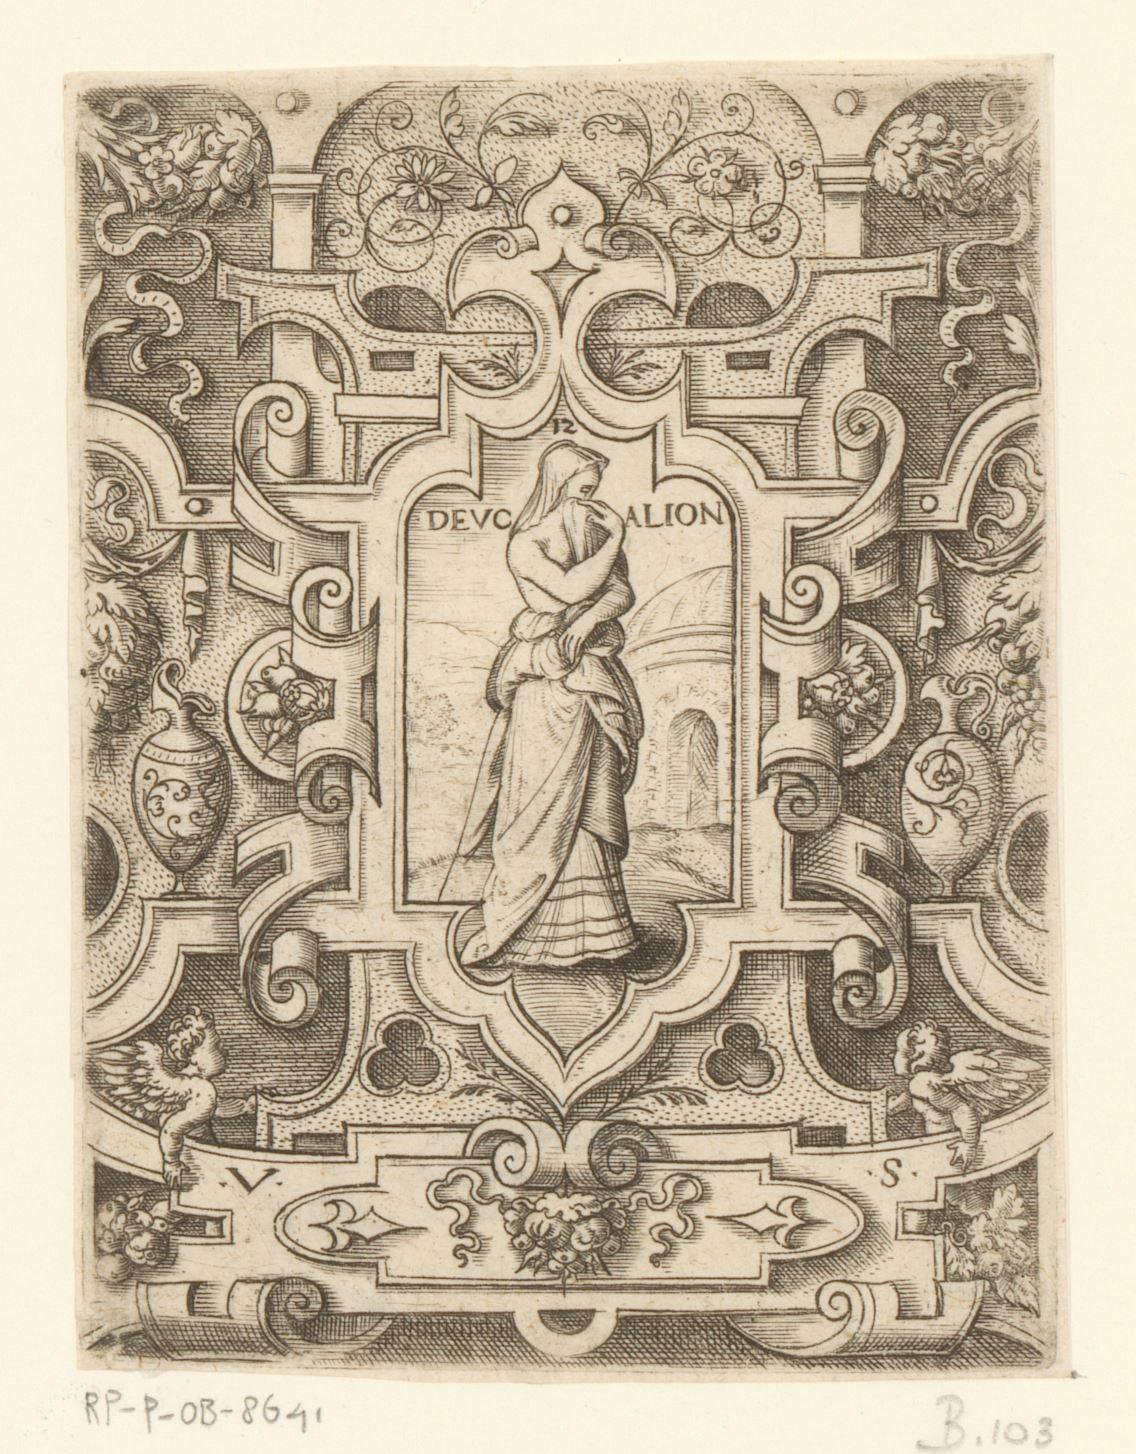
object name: print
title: Mythologische vrouwen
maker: virgilius solis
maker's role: draughtsman, print maker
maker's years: 1514-1562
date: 1524-1562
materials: paper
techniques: engraving, etching, intaglio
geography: nuremberg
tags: scrollwork, strapwork ~ ornament, deucalion's flood; jupiter sends a great flood to destroy mankind; deucalion and pyrrha afloat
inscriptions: collector's mark: Lugt 2228, number: ‘123’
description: Maakt deel uit van een serie van twaalf prenten met vrouwelijke mythologische figuren staand in rolwerk omlijstingen.